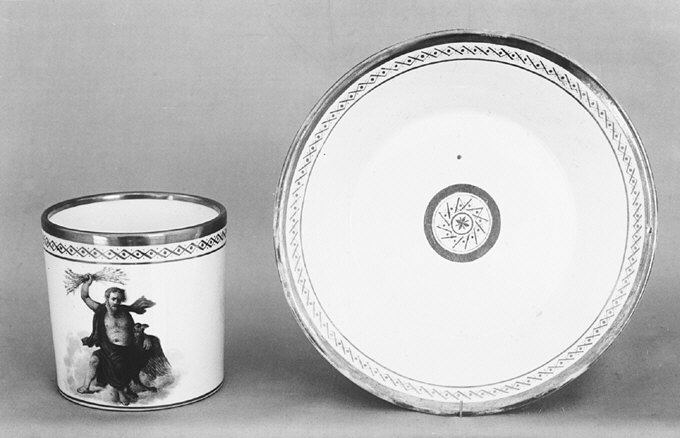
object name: saucer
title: Saucer (part of a coffee service)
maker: nymphenburg porcelain manufactory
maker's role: manufactory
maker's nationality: german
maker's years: 1747-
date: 1801-1833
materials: hard paste porcelain